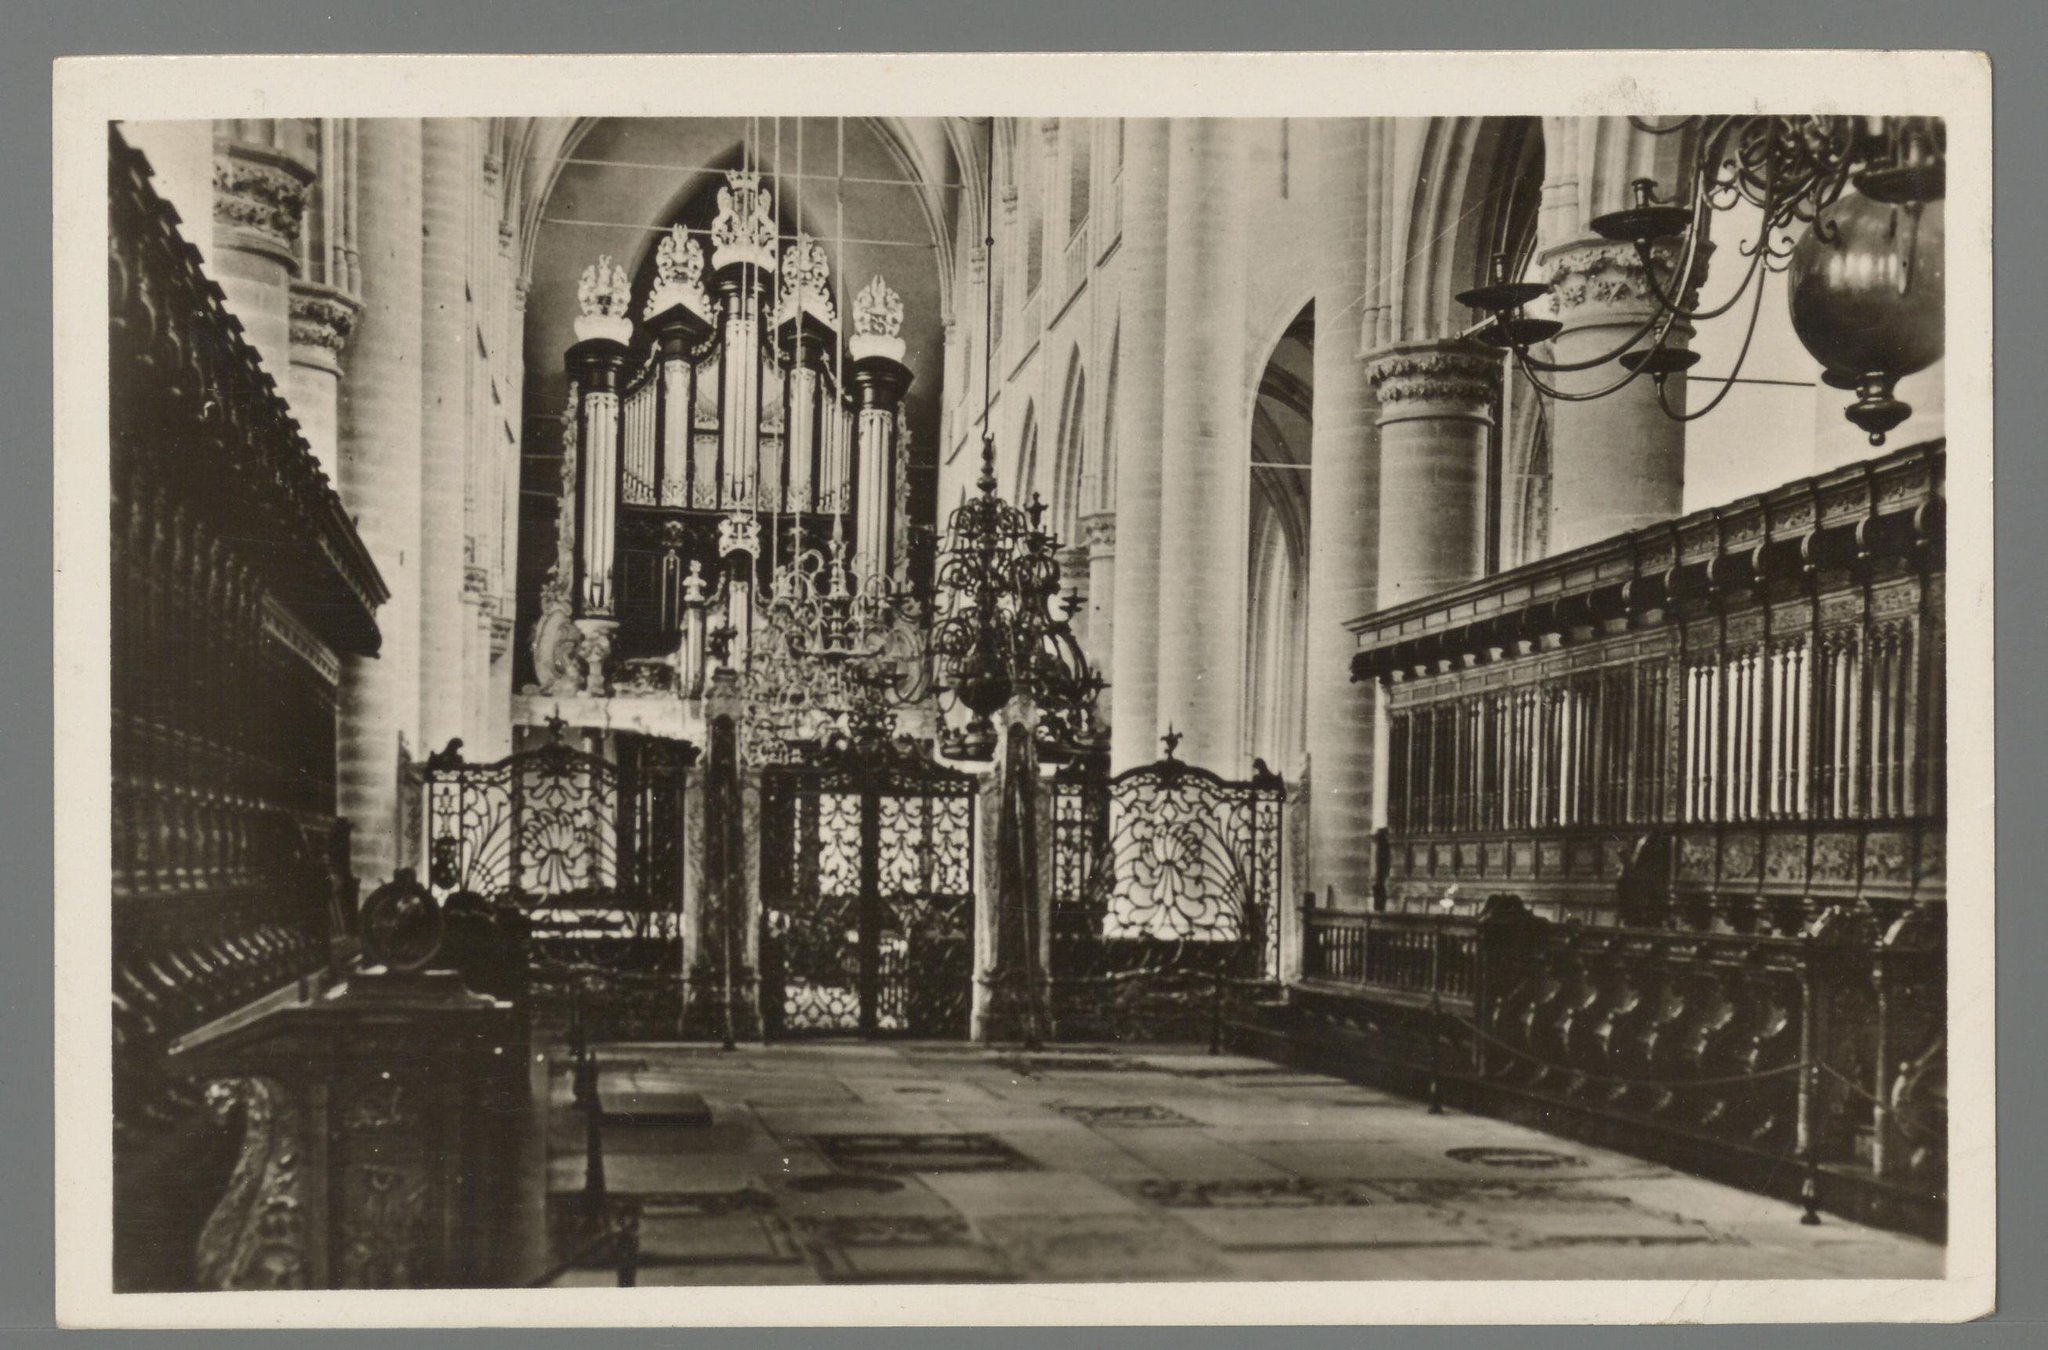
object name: ansichtkaart, prentbriefkaart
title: DORDRECHT./Interieur Grote Kerk./Interno de la Granda Pregejo.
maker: Anonymous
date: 1900-1930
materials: photographic support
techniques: photography, writing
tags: church organ, parts of church interior, gouda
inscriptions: postage stamp